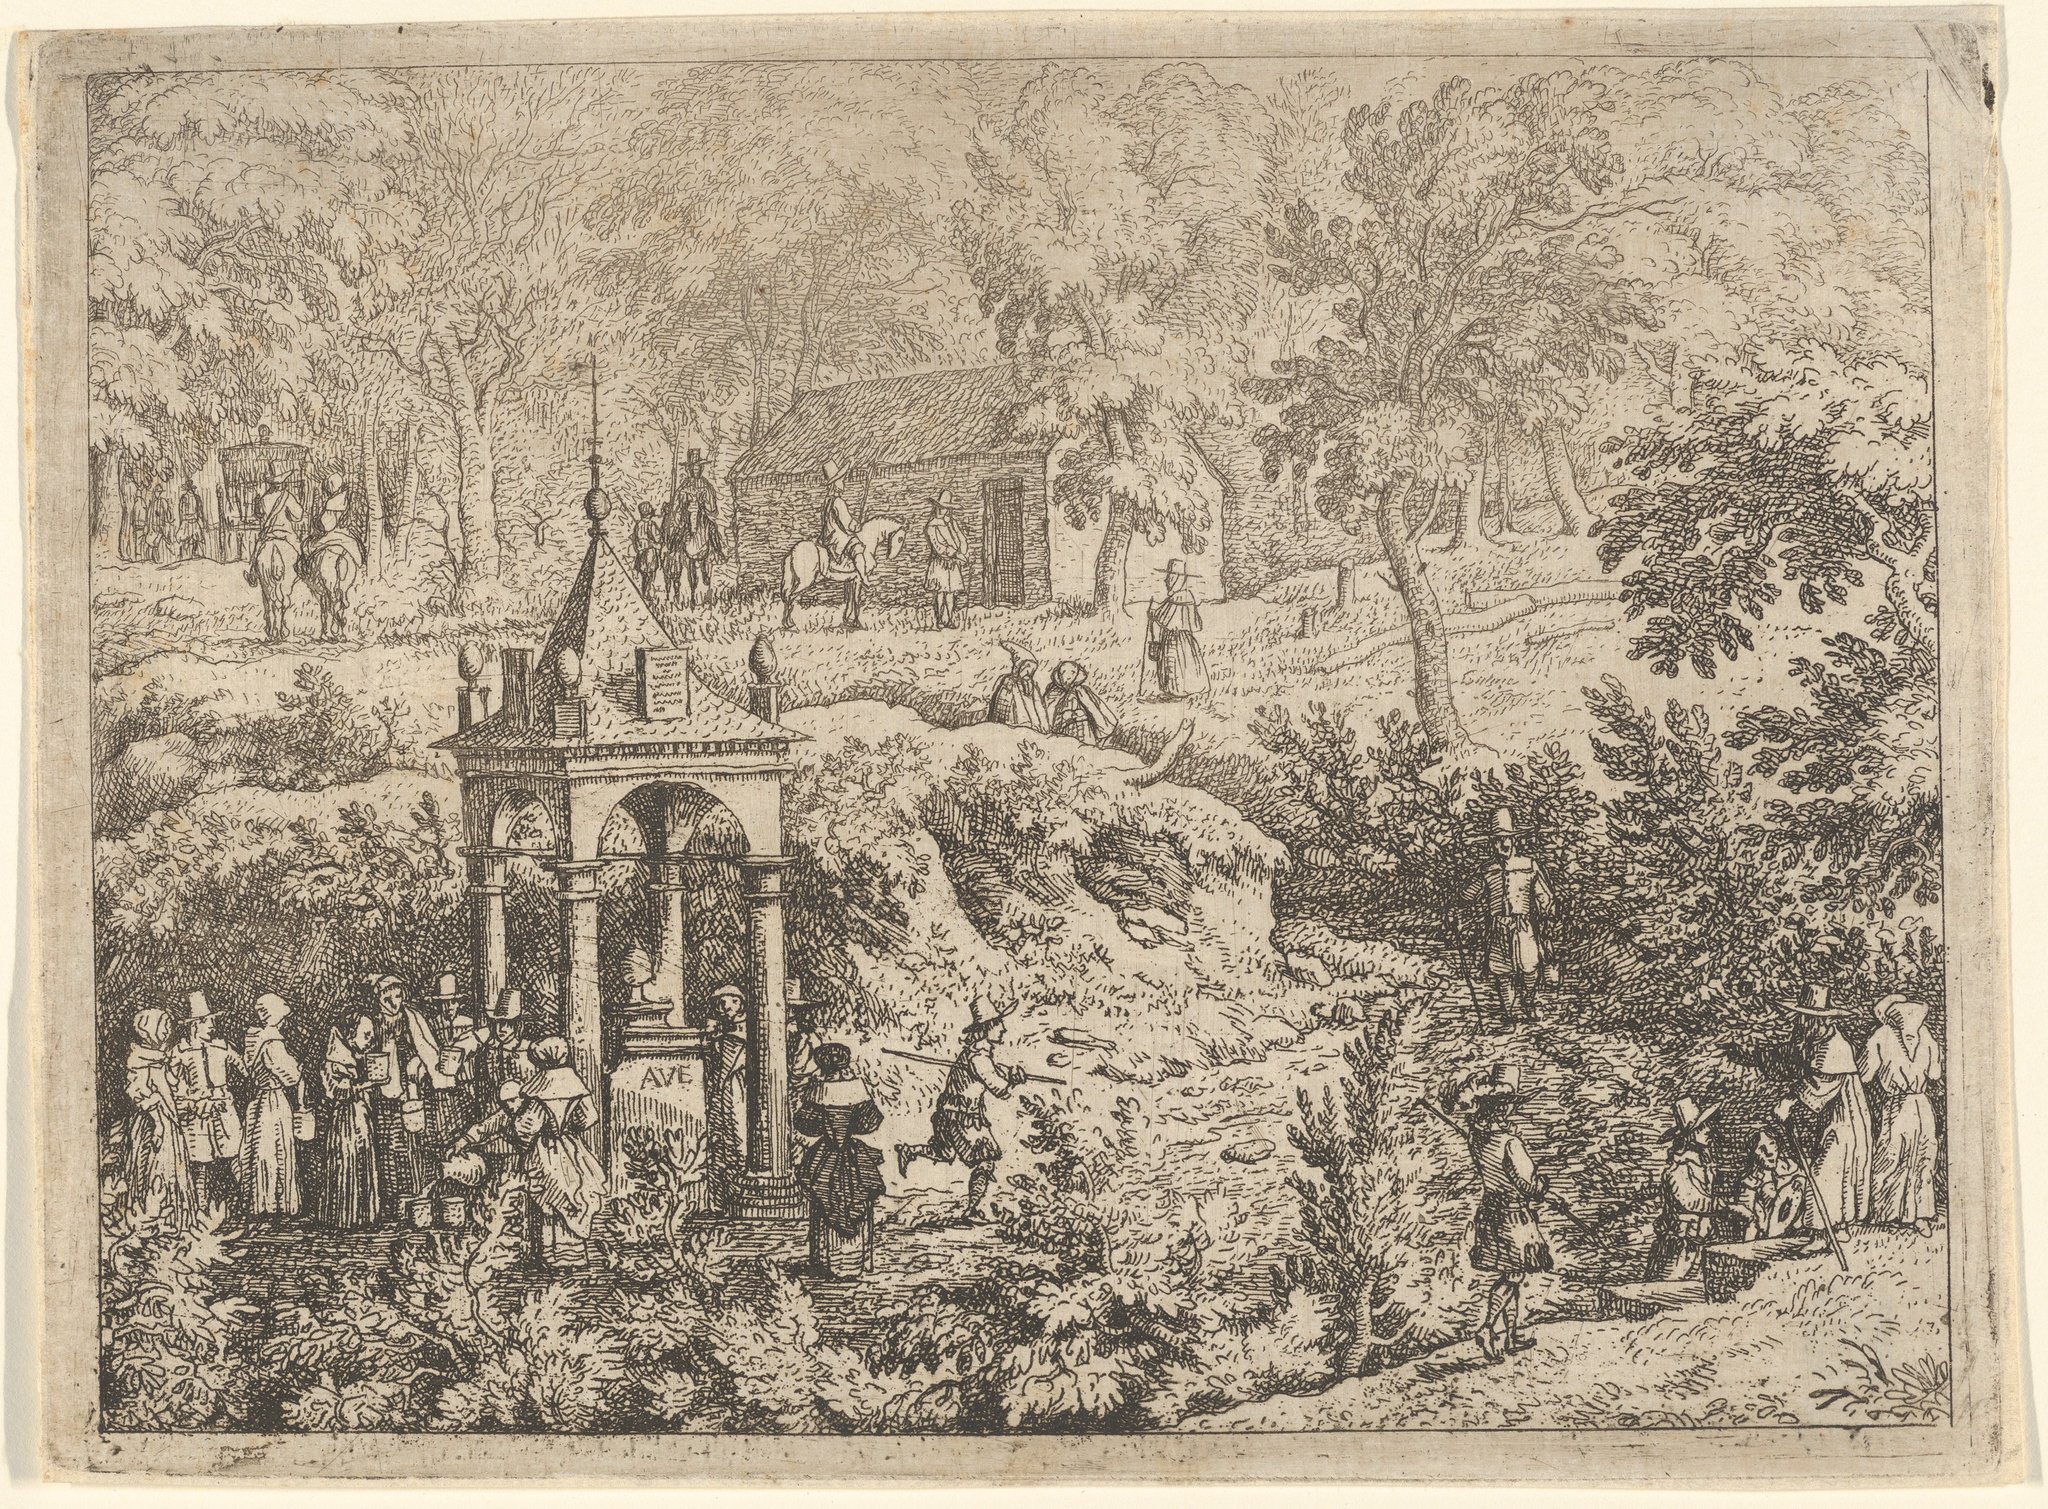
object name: print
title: The Third Spring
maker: allart van everdingen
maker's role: artist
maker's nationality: dutch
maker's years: 1621-1675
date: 1621-1675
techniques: engraving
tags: men,women,landscapes